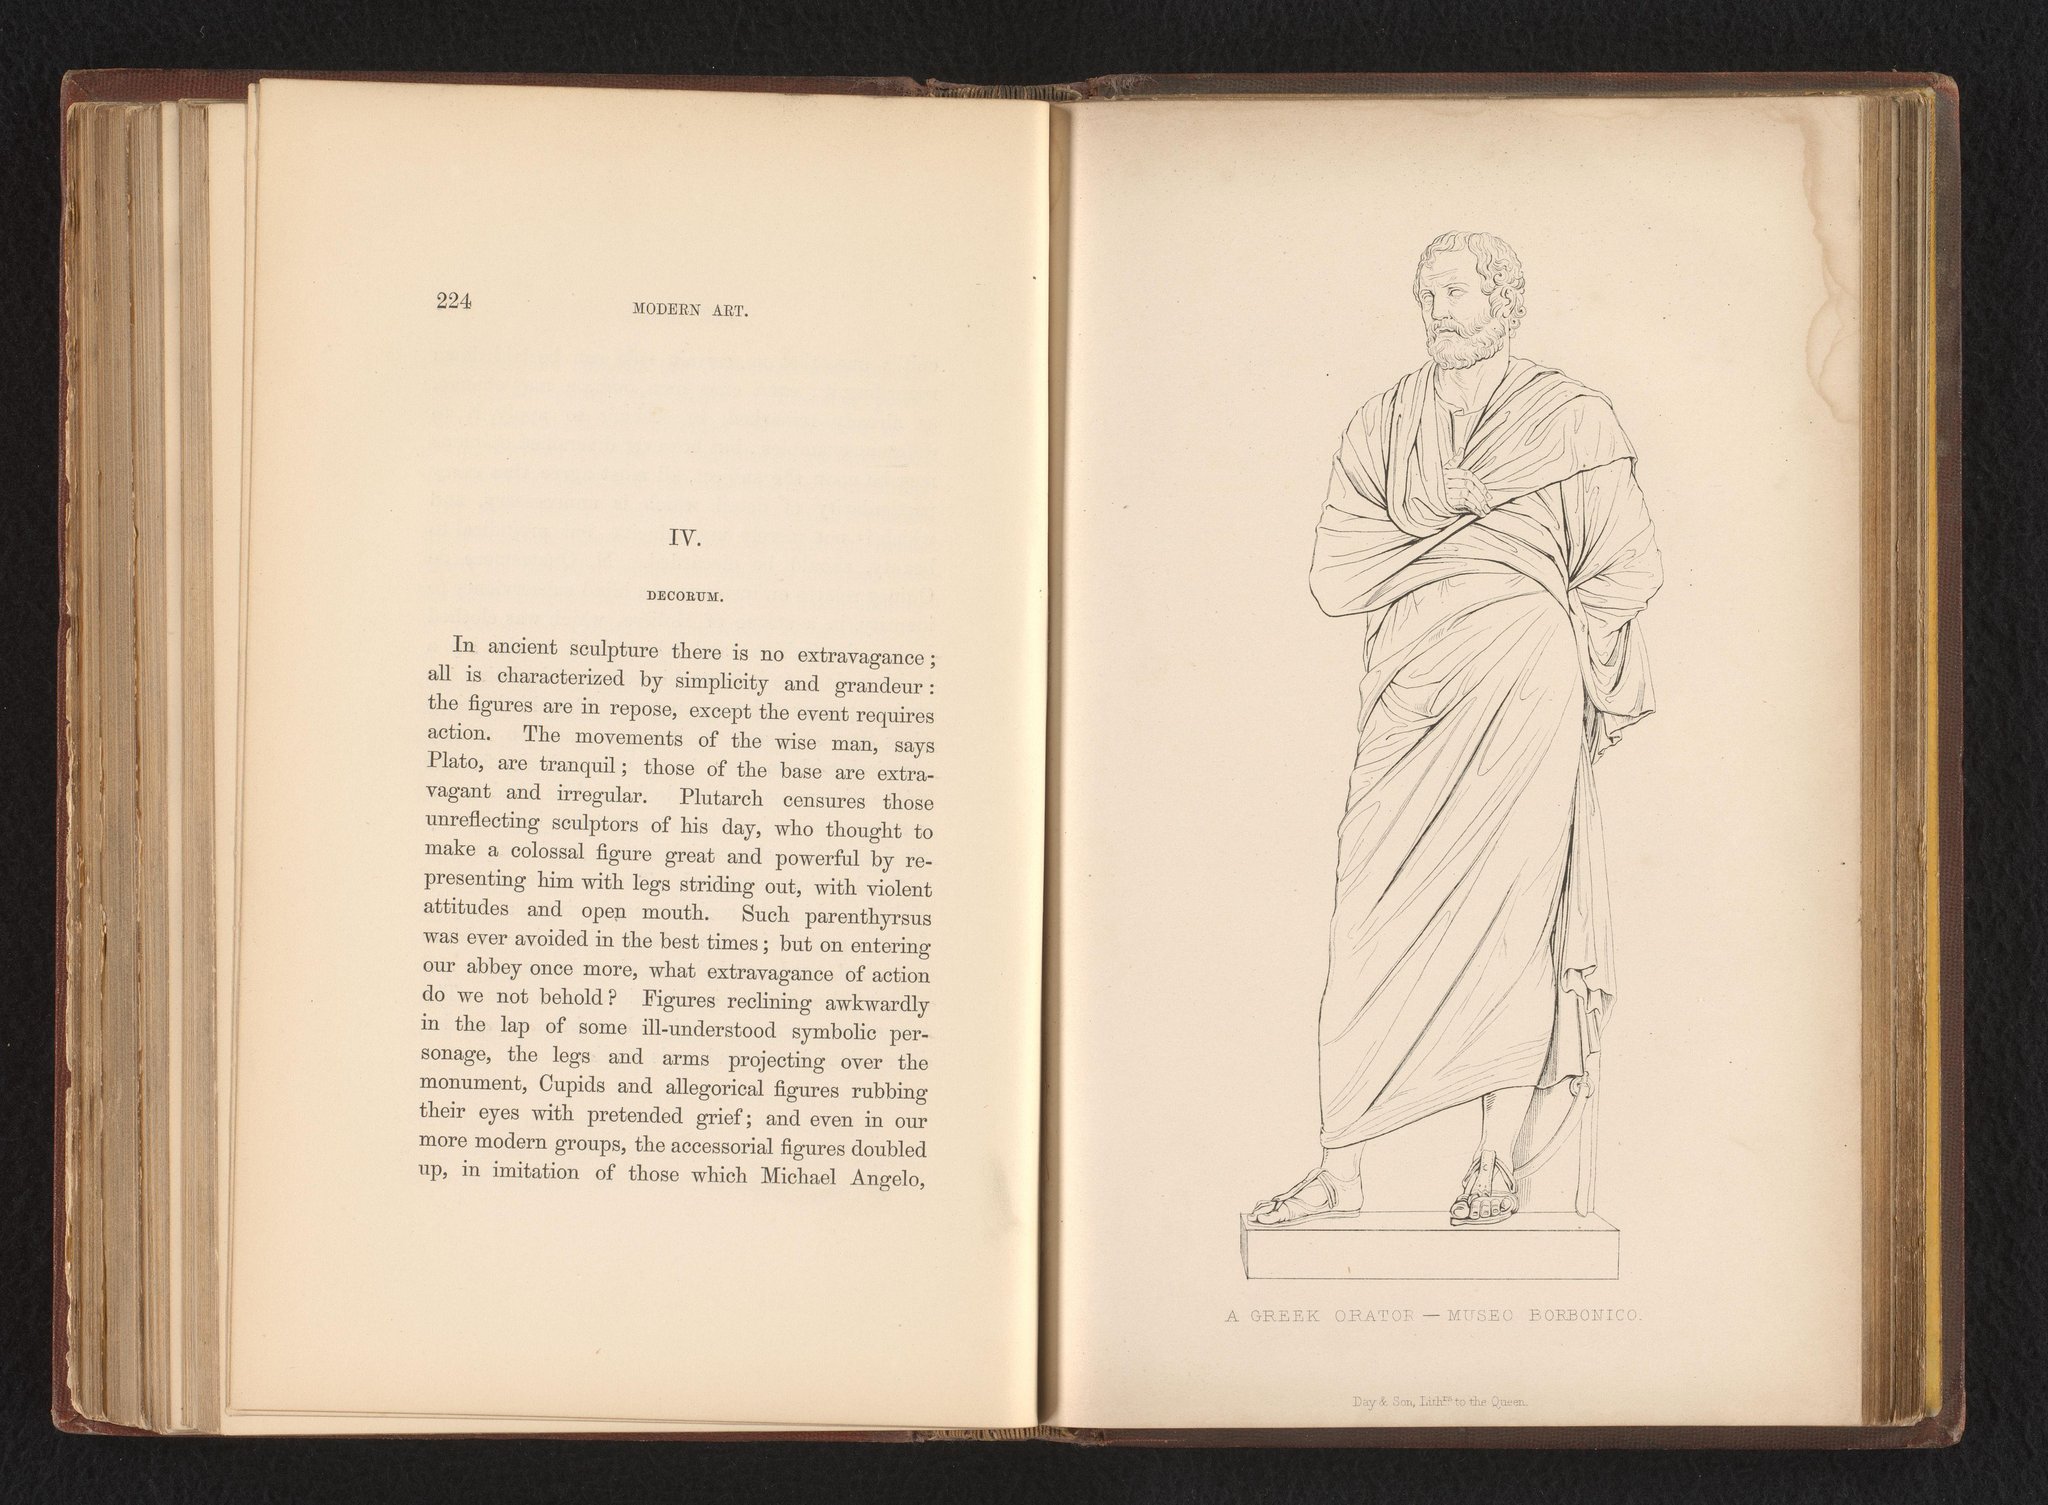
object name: page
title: Griekse redenaar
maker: Anonymous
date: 1855-1860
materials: paper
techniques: lithograph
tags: person addressing a group, orator